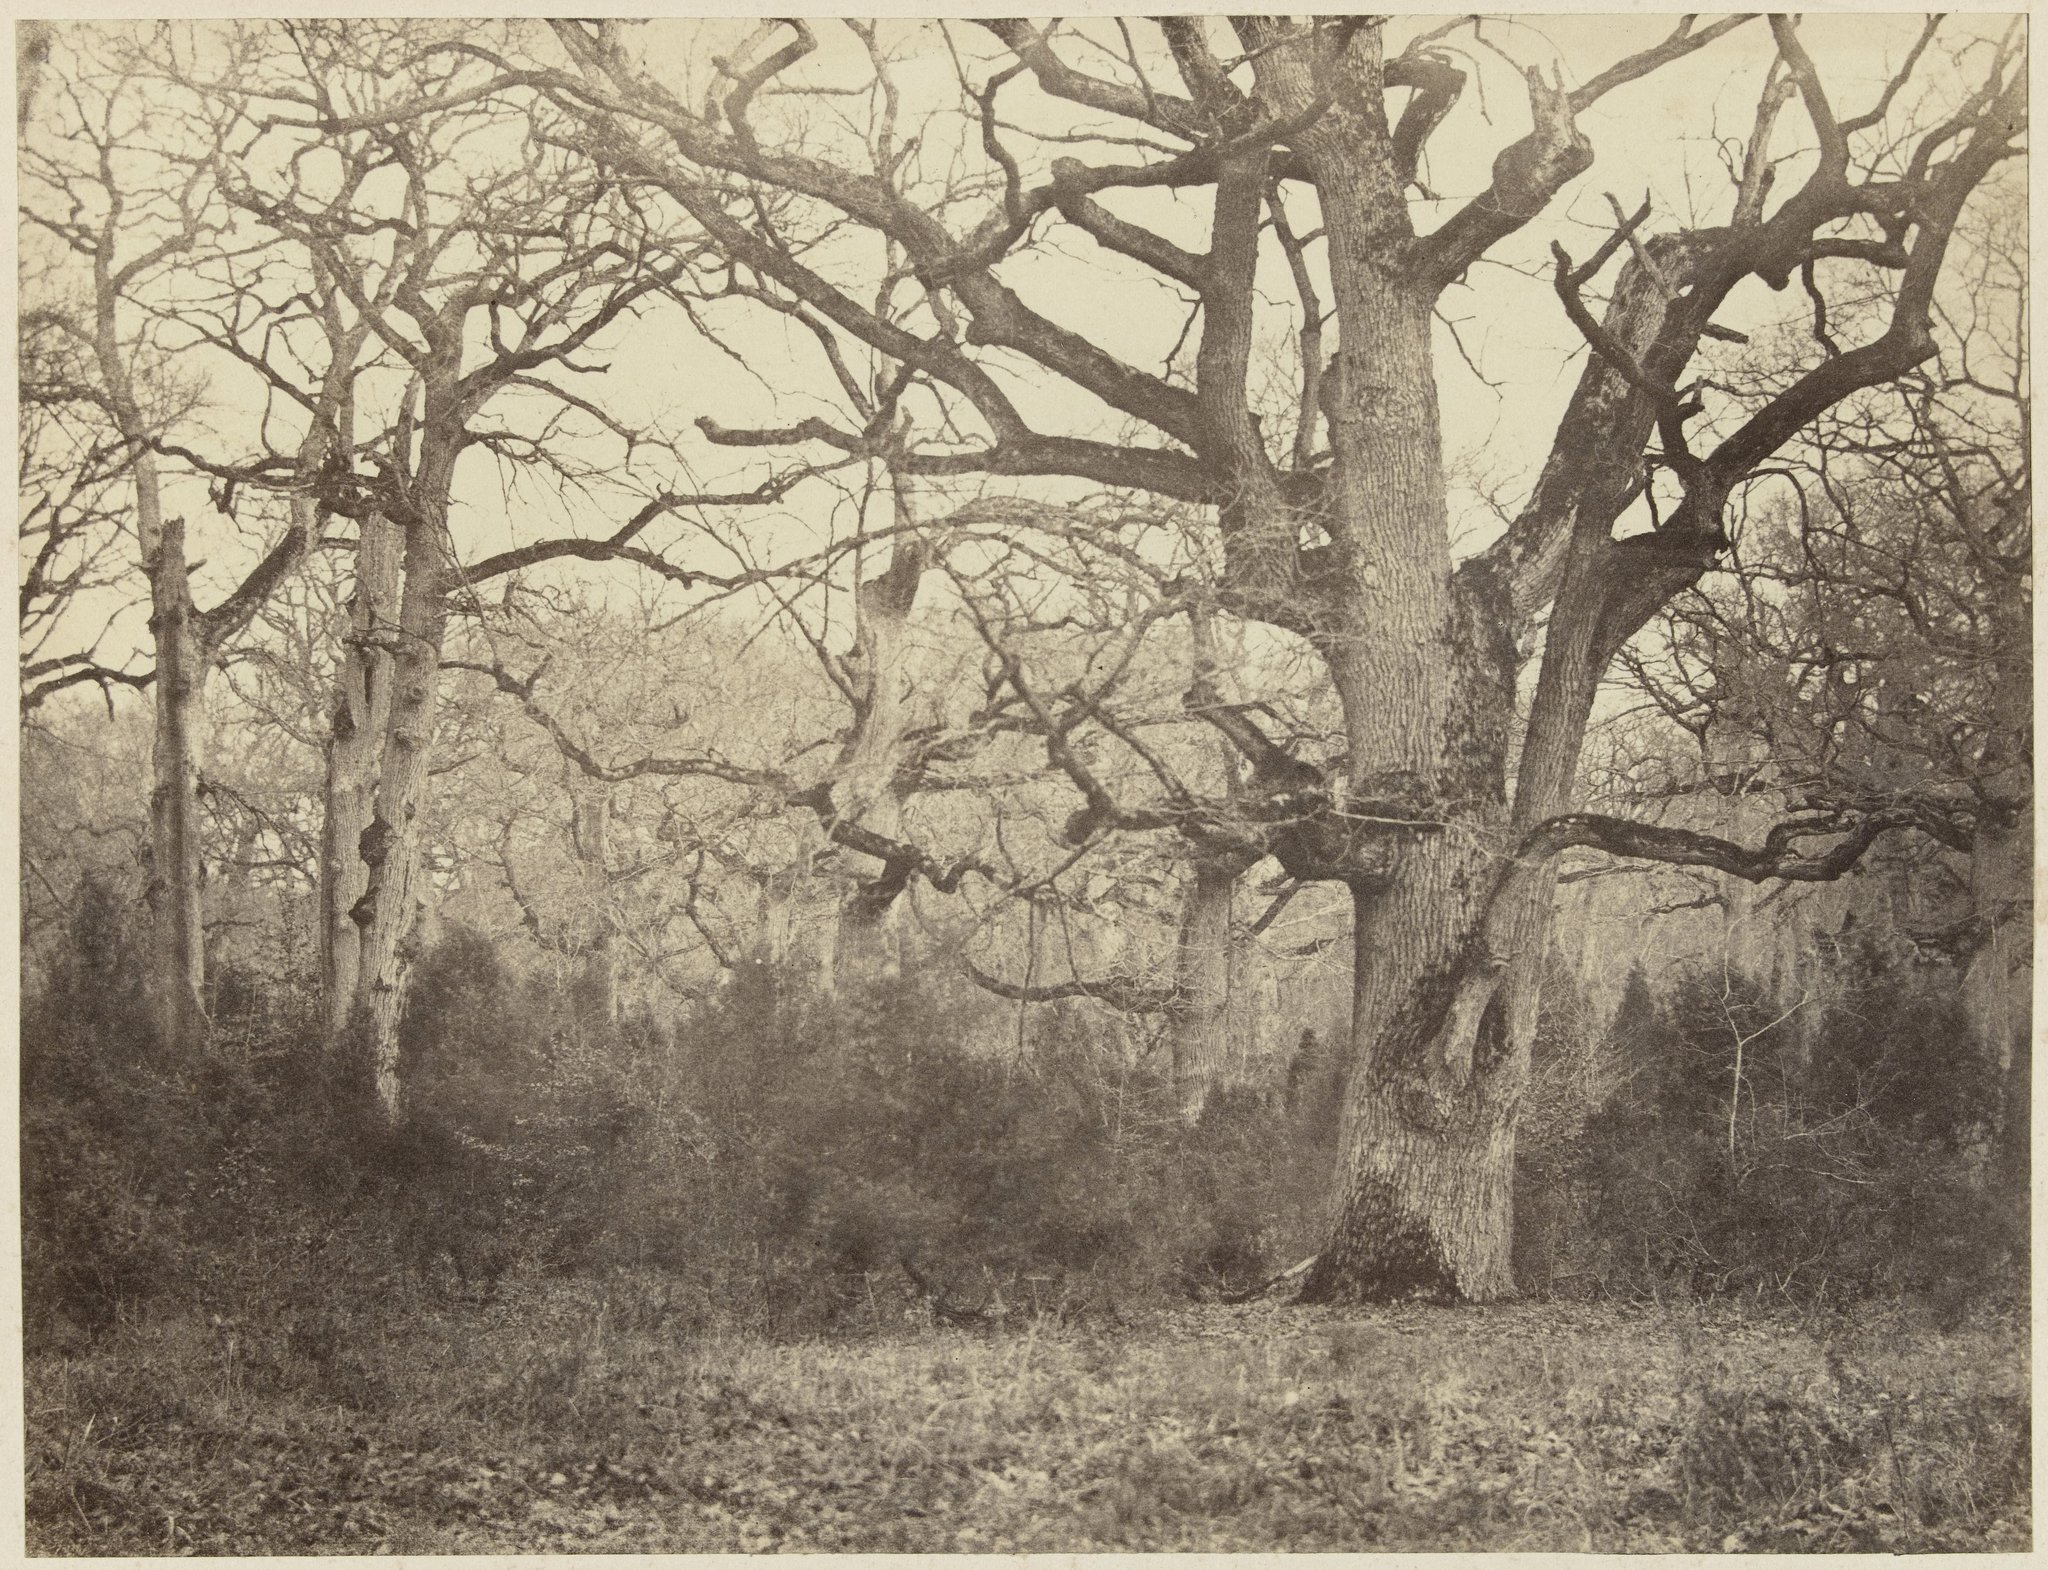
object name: photograph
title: Forest Landscape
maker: eugène cuvelier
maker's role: fotograaf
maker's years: 1837-1900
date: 1860-1870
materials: cardboard, paper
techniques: albumen print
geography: france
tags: forest, wood, france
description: Both painters and photographers worked in Fontainebleau Forest. In choosing forest landscapes, photography and art came very close together. Cuvelier used paper negatives, which yielded a softer focus than glass negatives: in making the print, the paper fibre of the negative was also printed. Had he made negatives using ‘modern’ textureless glass, the outlines would have been harder.